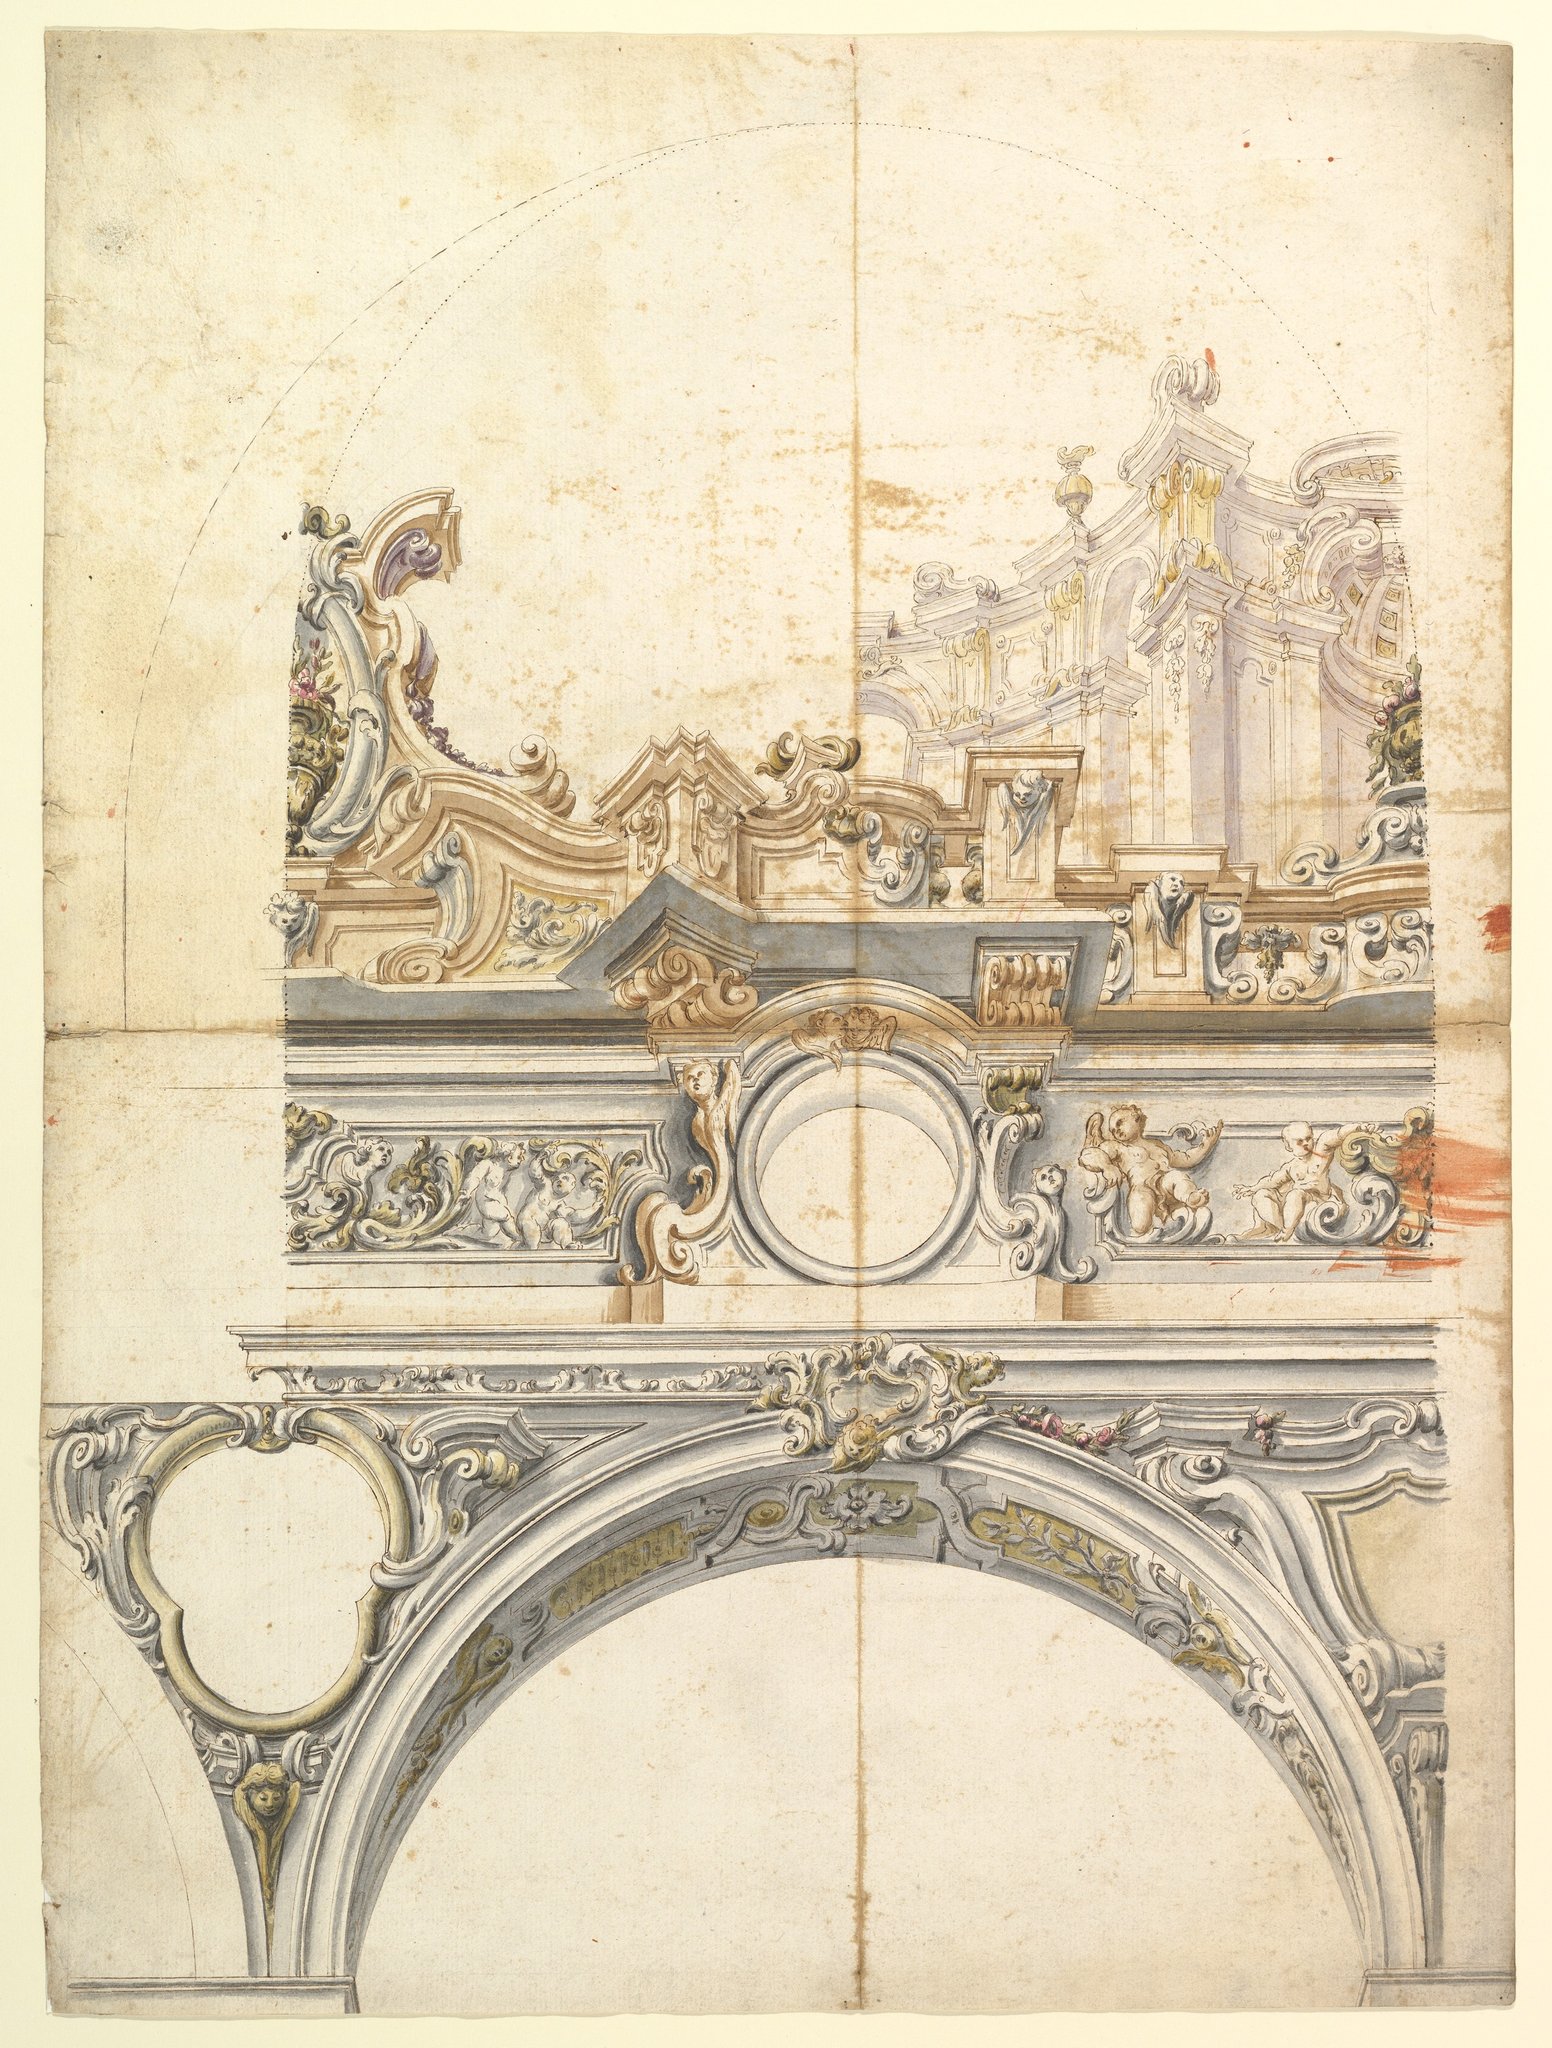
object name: drawing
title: Two Alternate Designs for a Balustrade with Architectural Perspective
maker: anonymous, italian, piedmontese, 18th century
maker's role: artist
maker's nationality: italian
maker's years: 1700-1800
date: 1700-1780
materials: graphite, ink, drawing material, watercolor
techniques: brush, pen, wash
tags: architecture